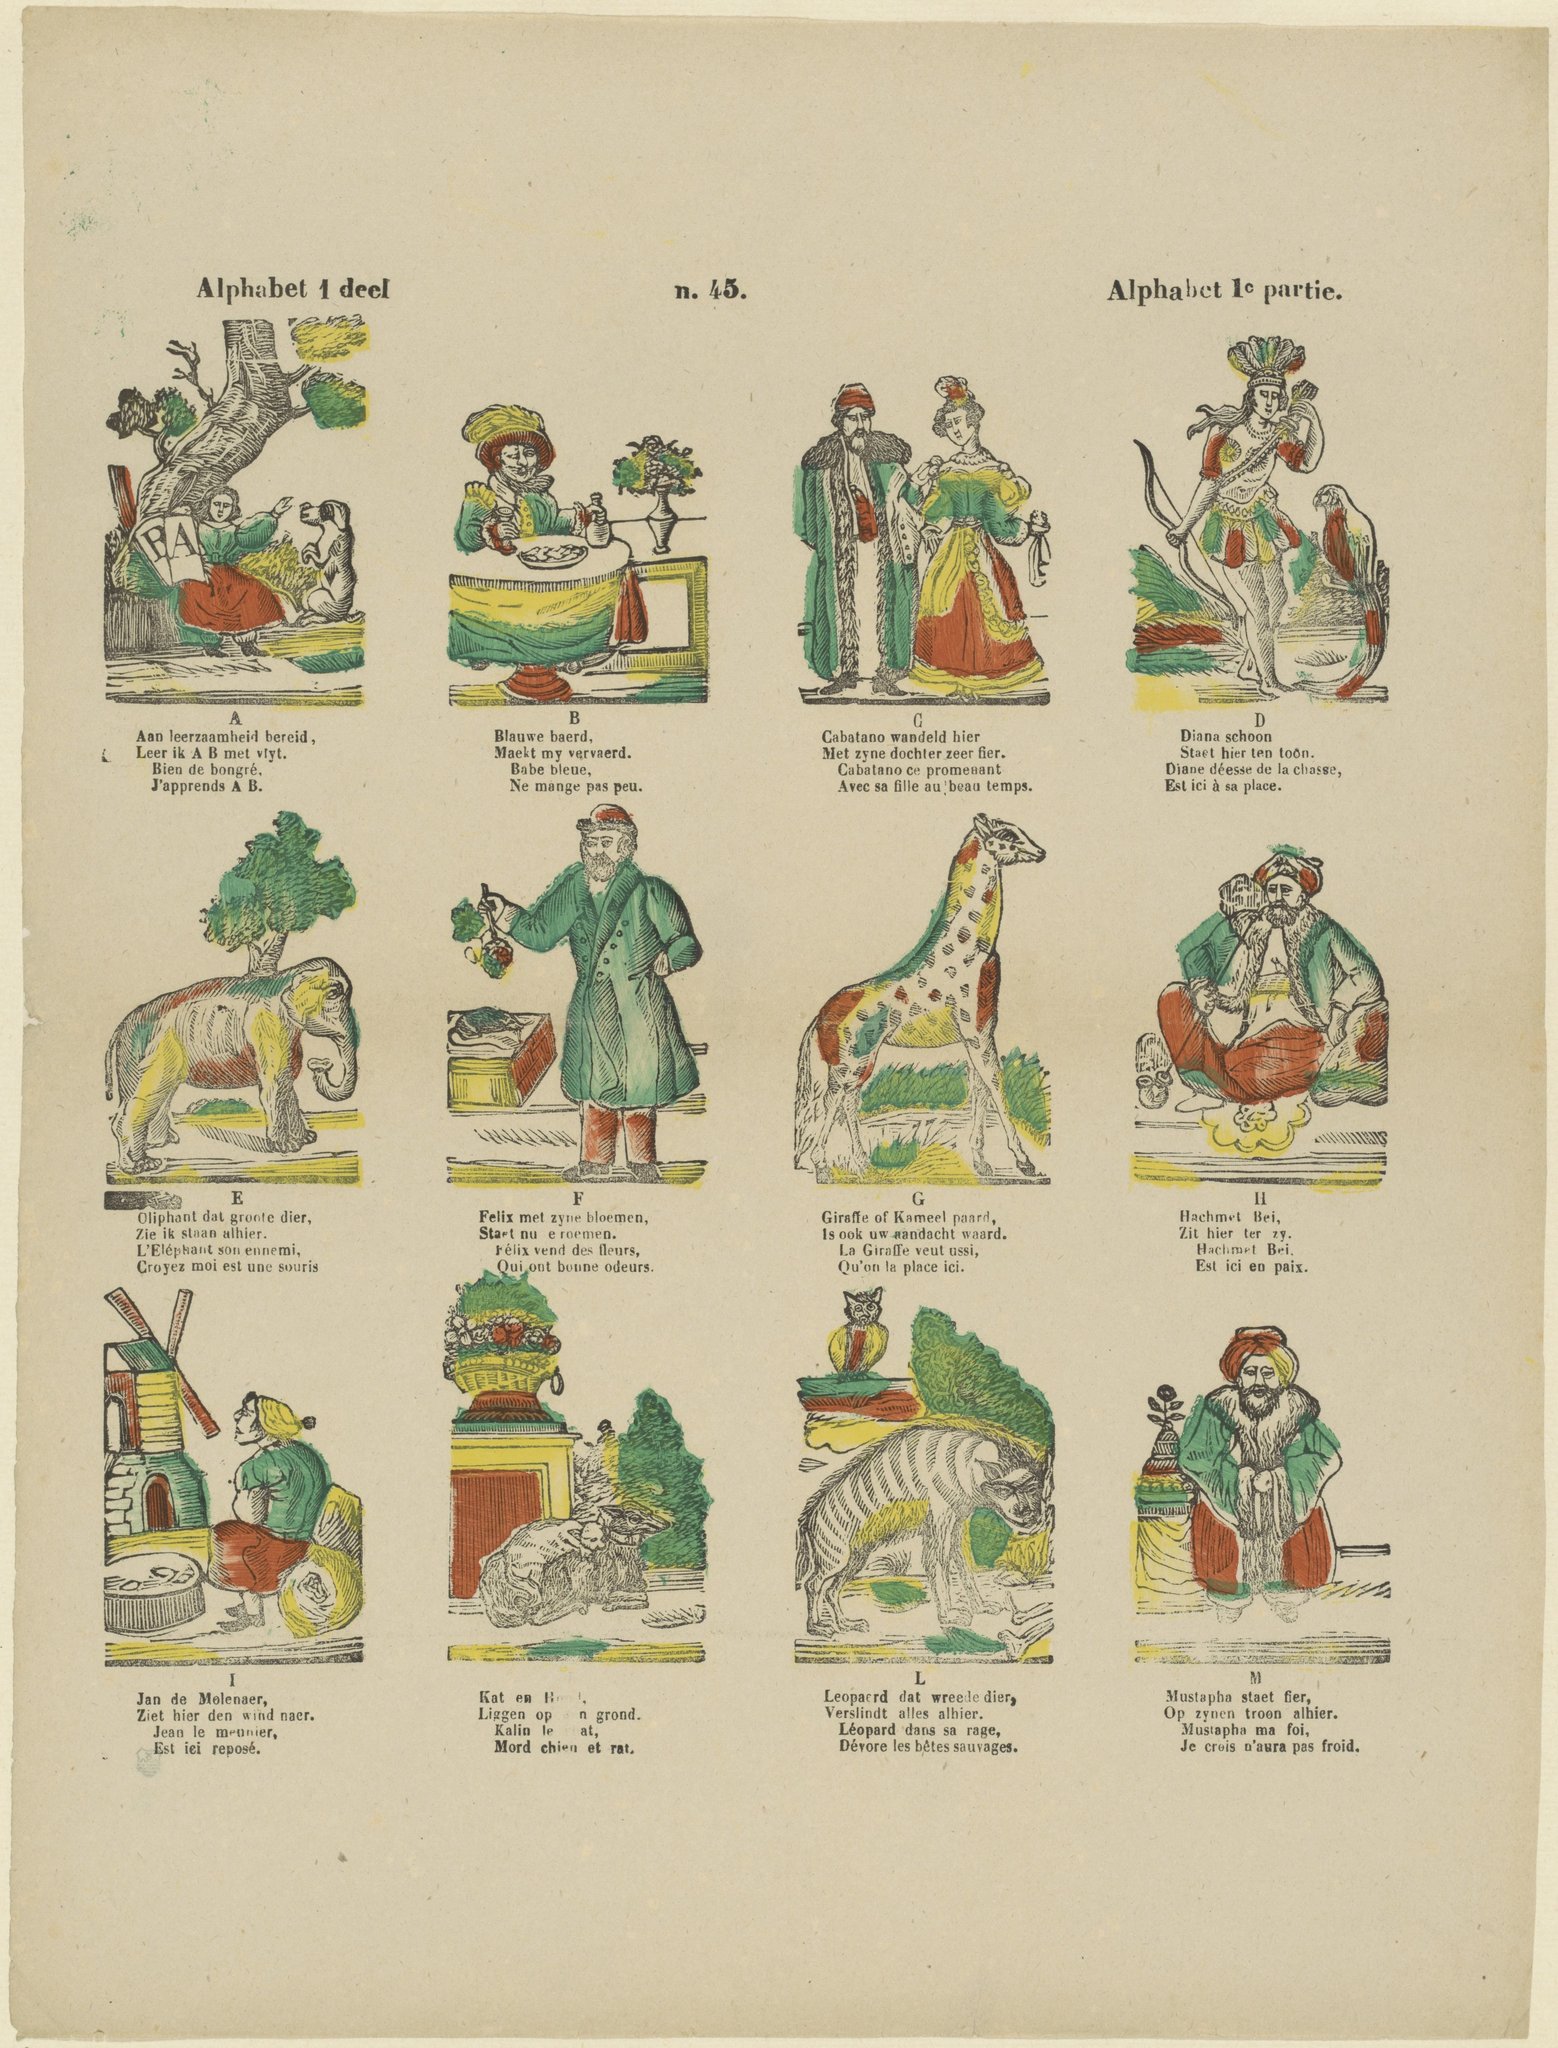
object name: popular print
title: Alphabet 1 deel / Alphabet 1e partie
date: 1866-1902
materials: paper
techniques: colour, letterpress printing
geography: europe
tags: animals, letters, alphabet, script, characters (human types)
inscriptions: collector's mark: Lugt 2760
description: Blad met 12 voorstellingen van de letters van het alfabet (A-M) geïllustreerd met dieren en figuren waarvan de woorden met de betreffende letter beginnen. Onder elke afbeelding een tweeregelig vers in het Nederlands en in het Frans. Genummerd midden boven: n. 45.